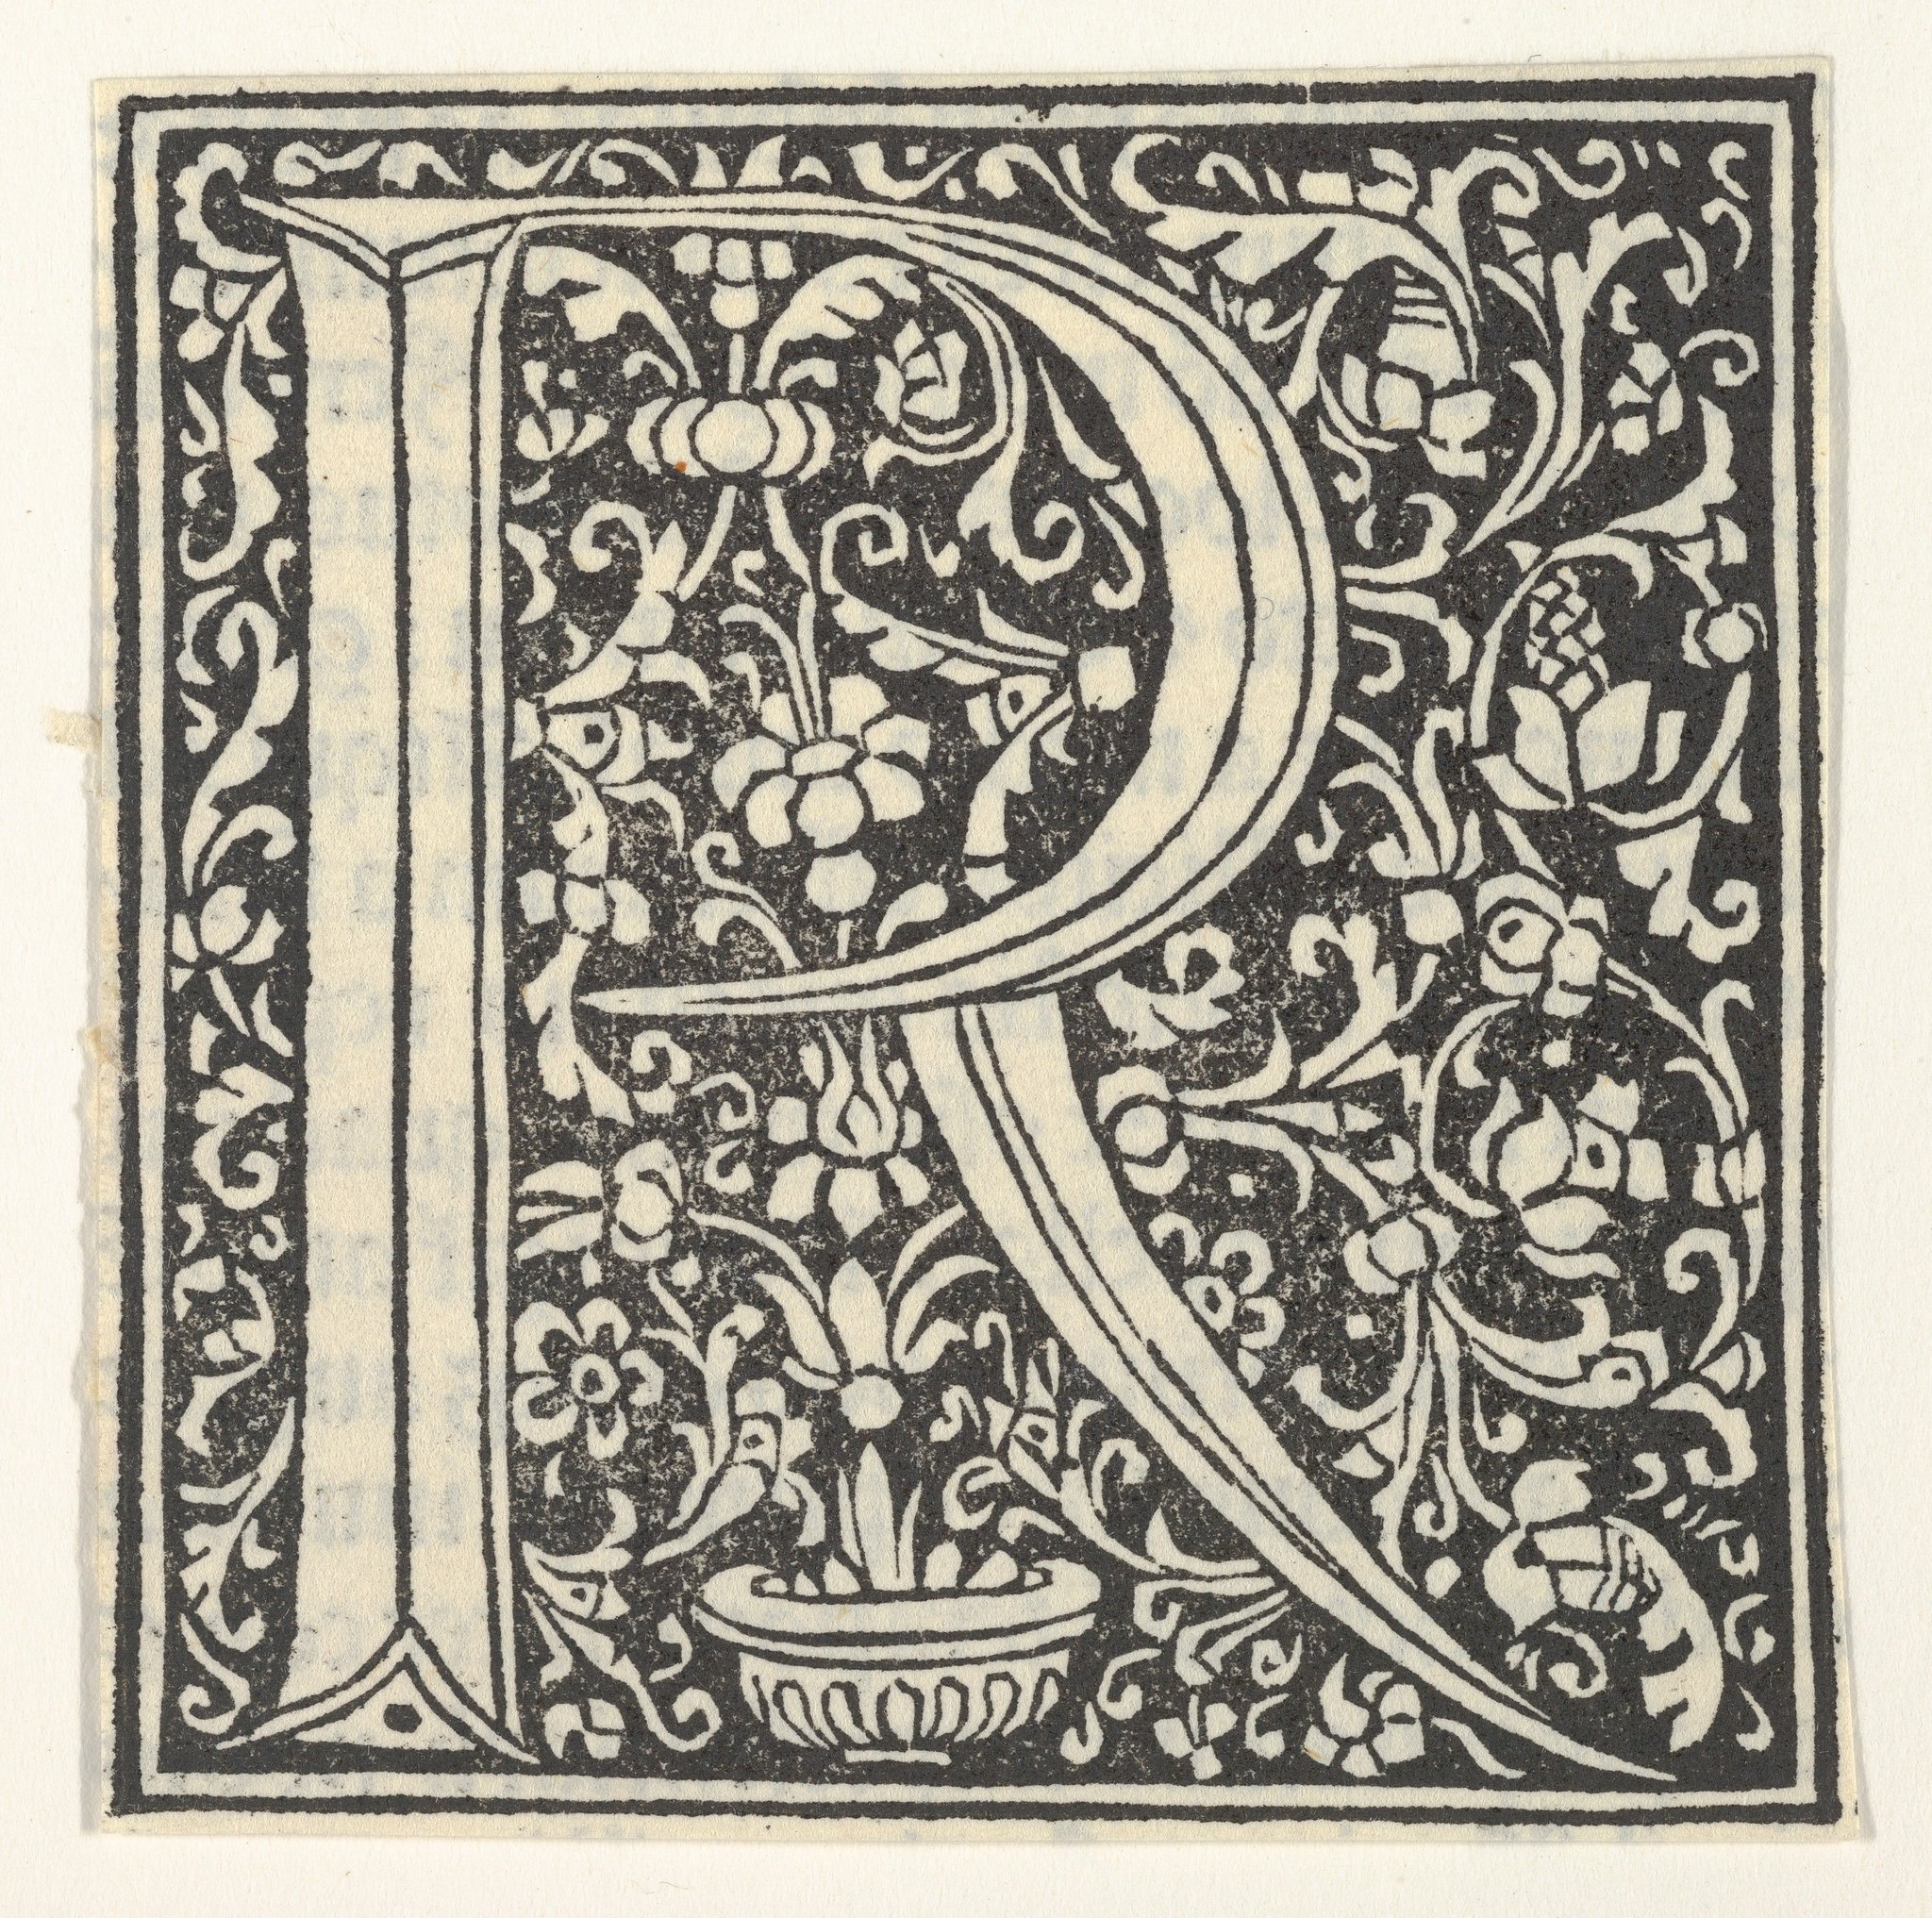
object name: print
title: Initial letter R with floral pattern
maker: anonymous, italian, 15th century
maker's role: artist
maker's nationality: italian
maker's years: 1400-1500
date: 1496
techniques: woodcut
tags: ornament,flowers